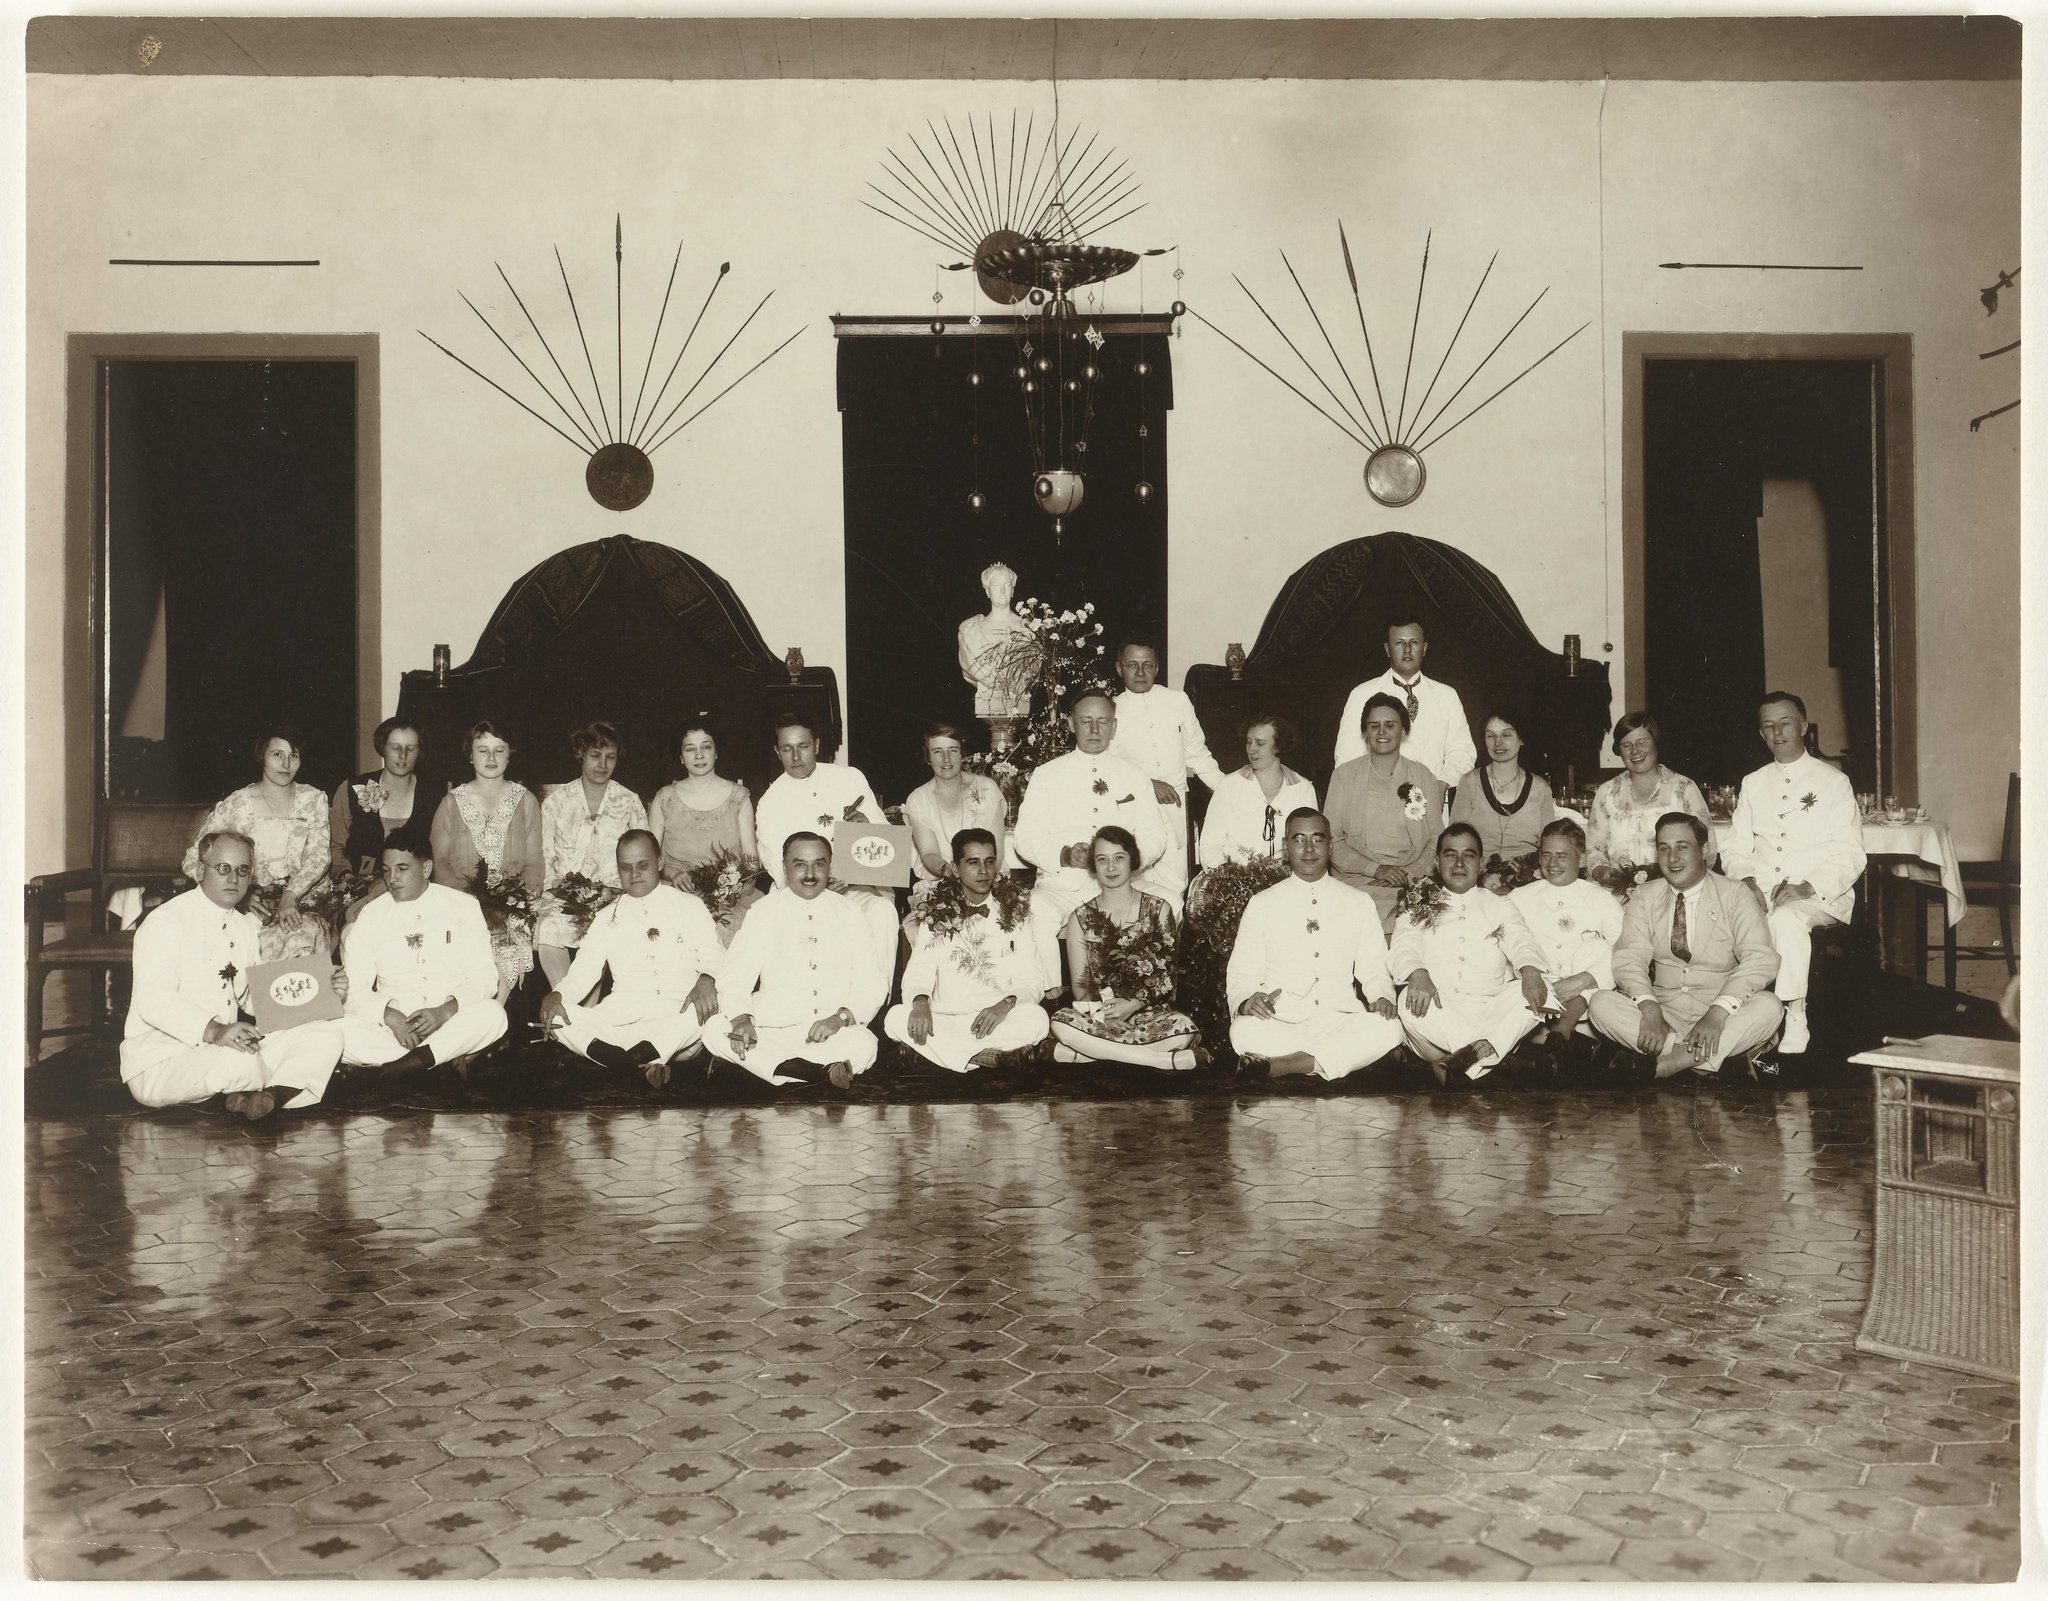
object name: photograph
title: Afscheidslunch Bertsch 3-12-1928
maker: Anonymous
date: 1928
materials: photographic support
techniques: photography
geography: solo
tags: letterie, solo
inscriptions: inscription: ‘afscheidslunch Bertsch 3-12-1928 gouv.huis Solo’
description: Afscheidslunch Bertsch 3-12-1928 in het gouverneurshuis te Solo, groepsportret.